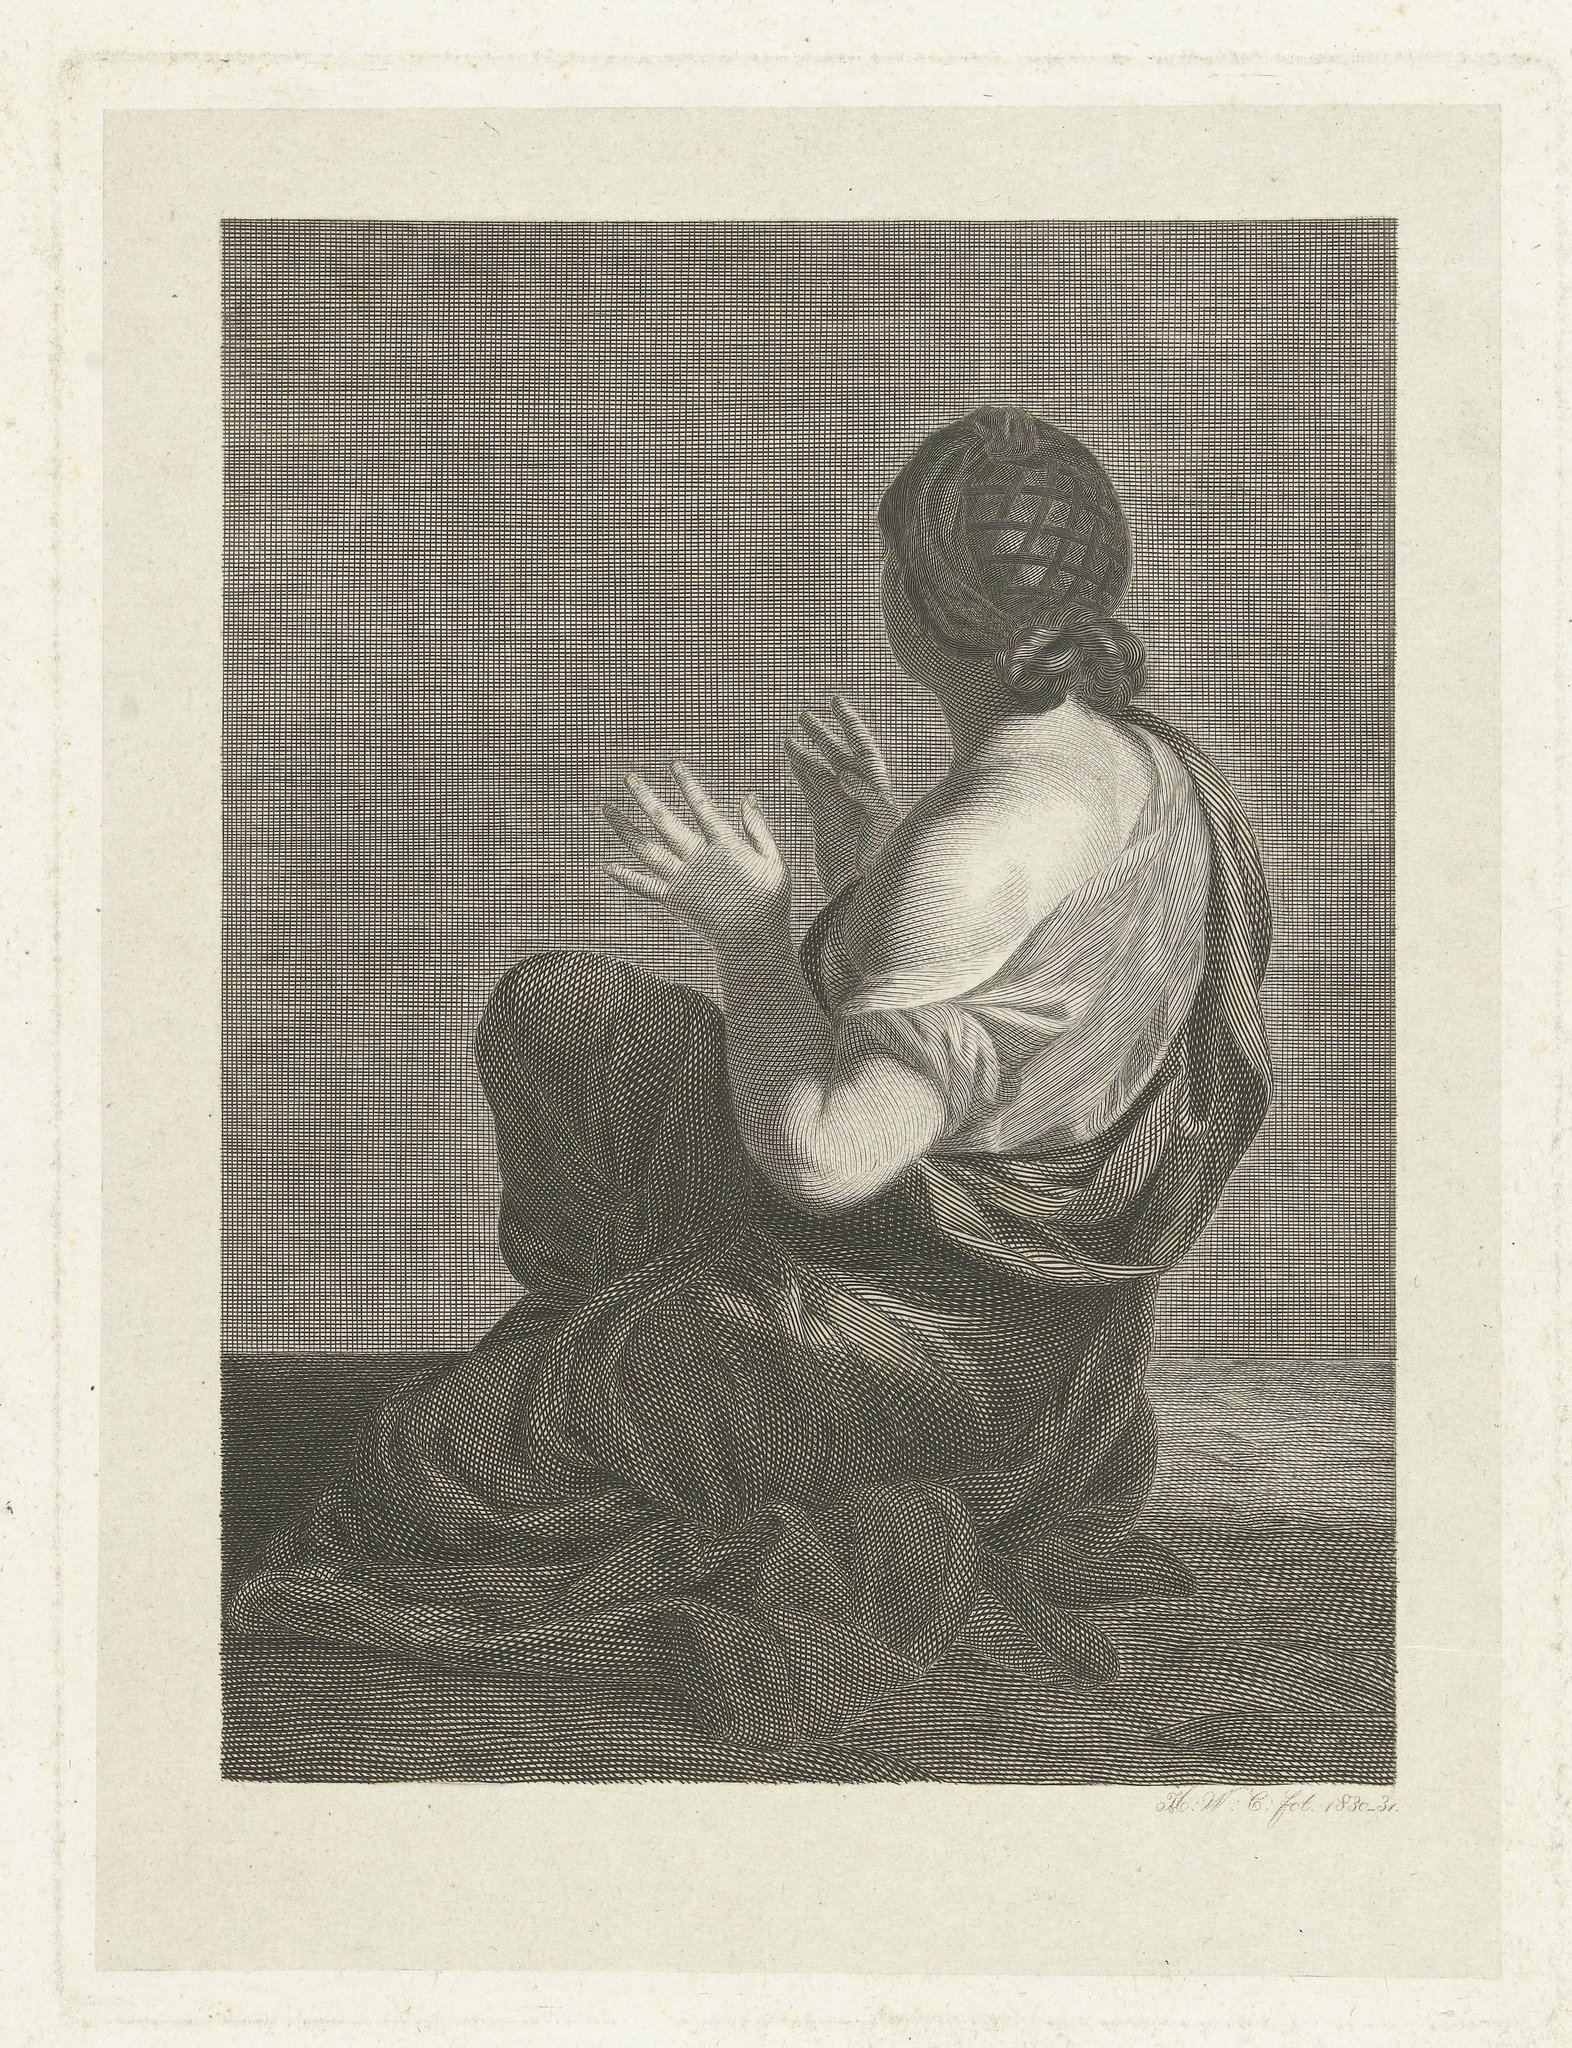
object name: print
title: Zittende vrouw op haar rug gezien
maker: henricus wilhelmus couwenberg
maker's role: draughtsman, print maker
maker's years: 1814-1845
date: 1830-1831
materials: paper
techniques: engraving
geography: amsterdam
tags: the (nude) human figure; 'corpo humano' (ripa) - aa - female human figure (+ back view with lost profile)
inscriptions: collector's mark: Lugt 2228